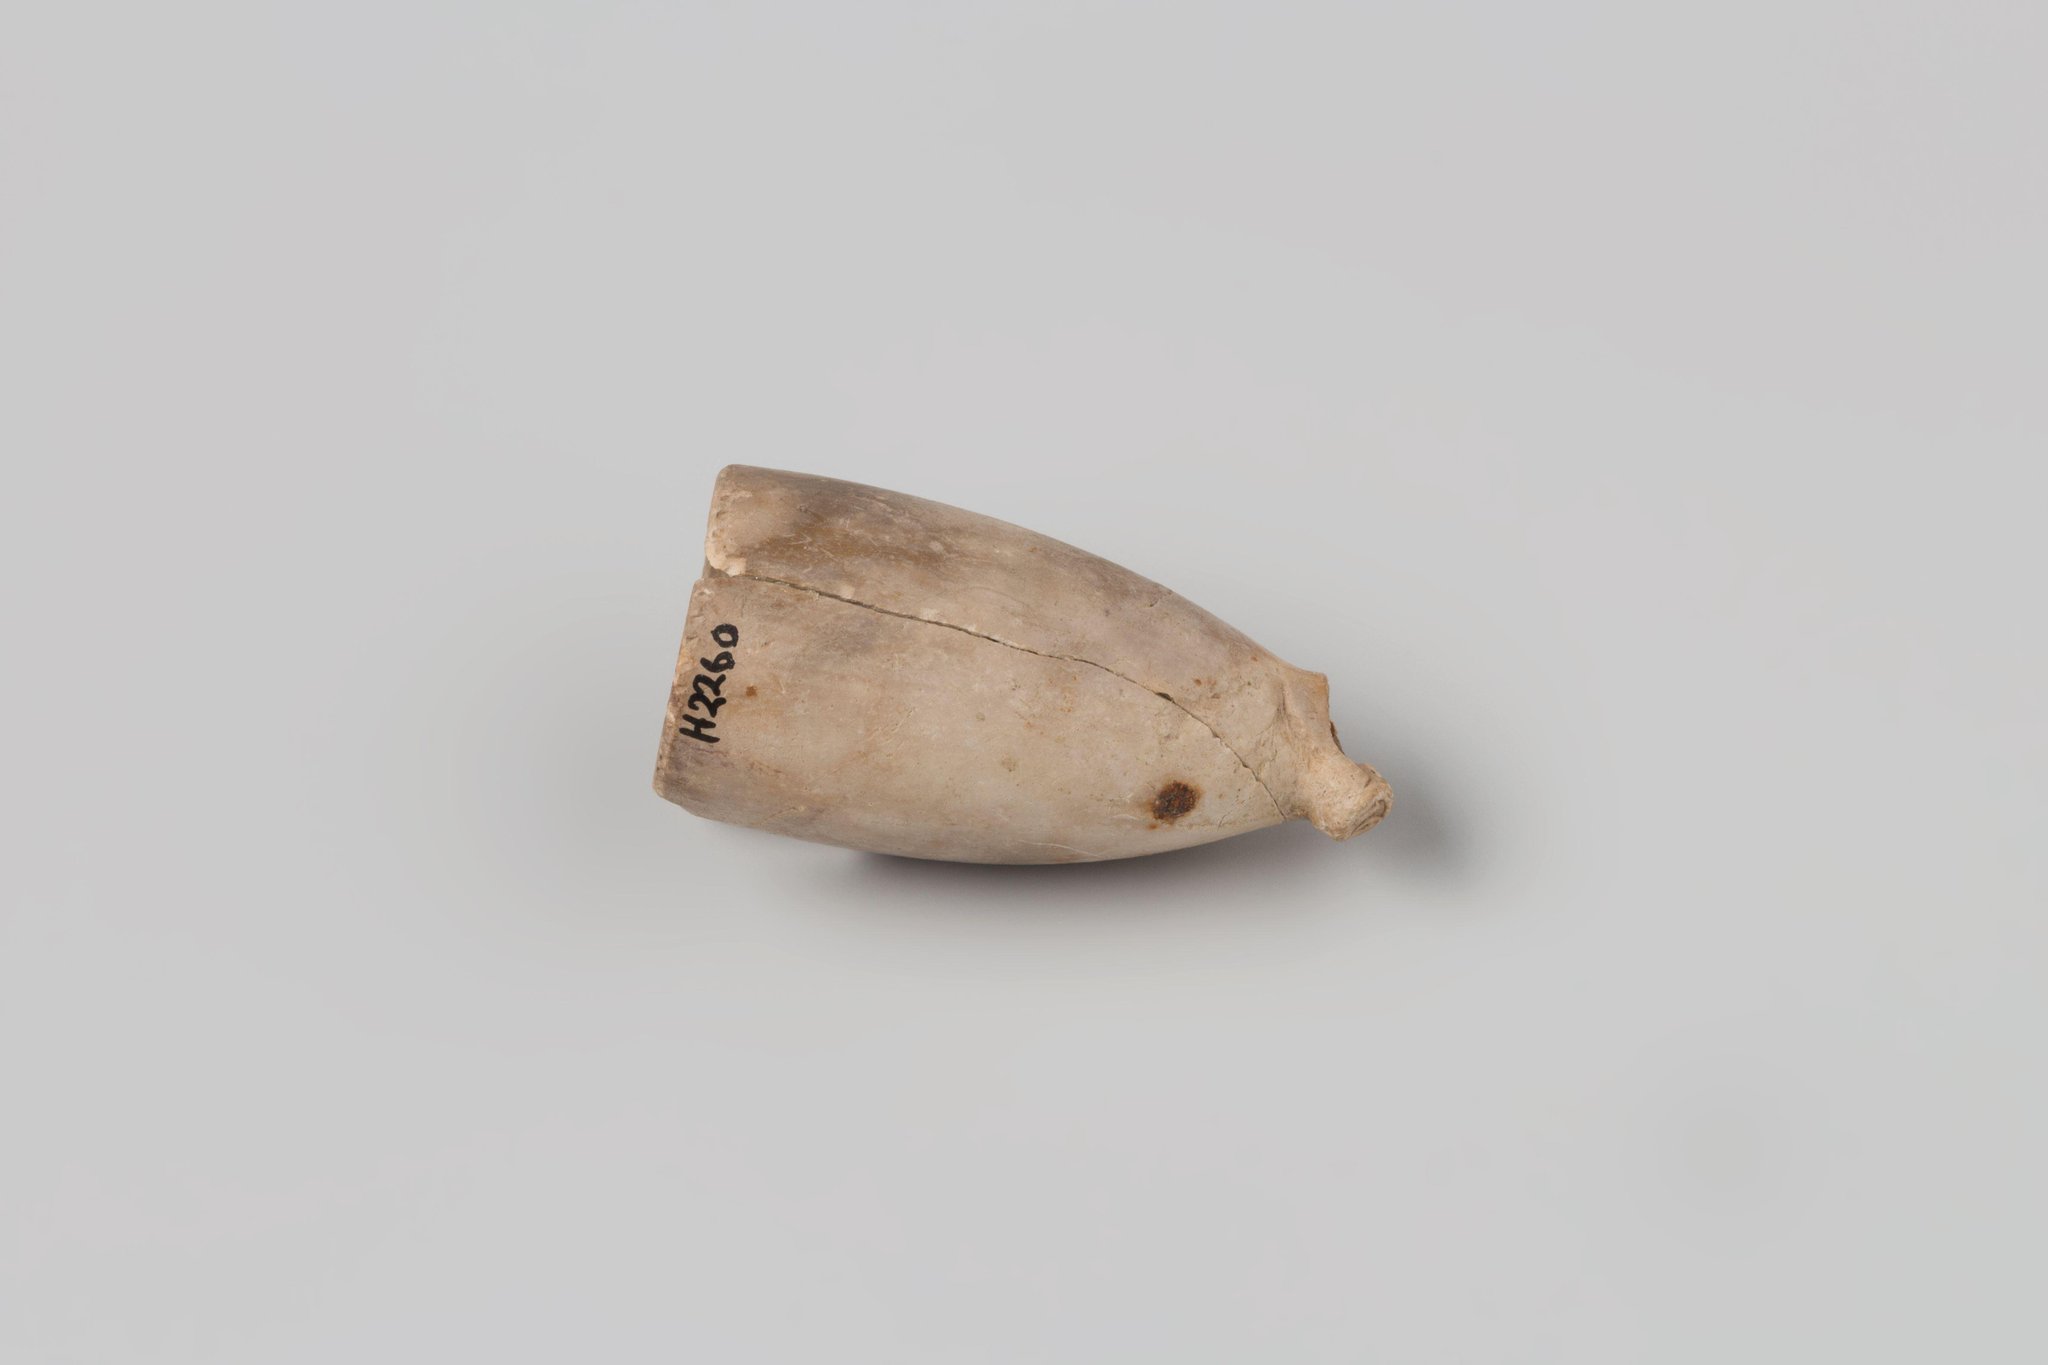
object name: pipe bowl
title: Pijpenkop uit het wrak van de Oost-Indiëvaarder Hollandia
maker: Anonymous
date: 1700-1743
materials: clay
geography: netherlands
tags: verenigde oostindische compagnie, hollandia (schip), annet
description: Pipe, bowl, heelmark: crowned 91; fragm, 1hms1.